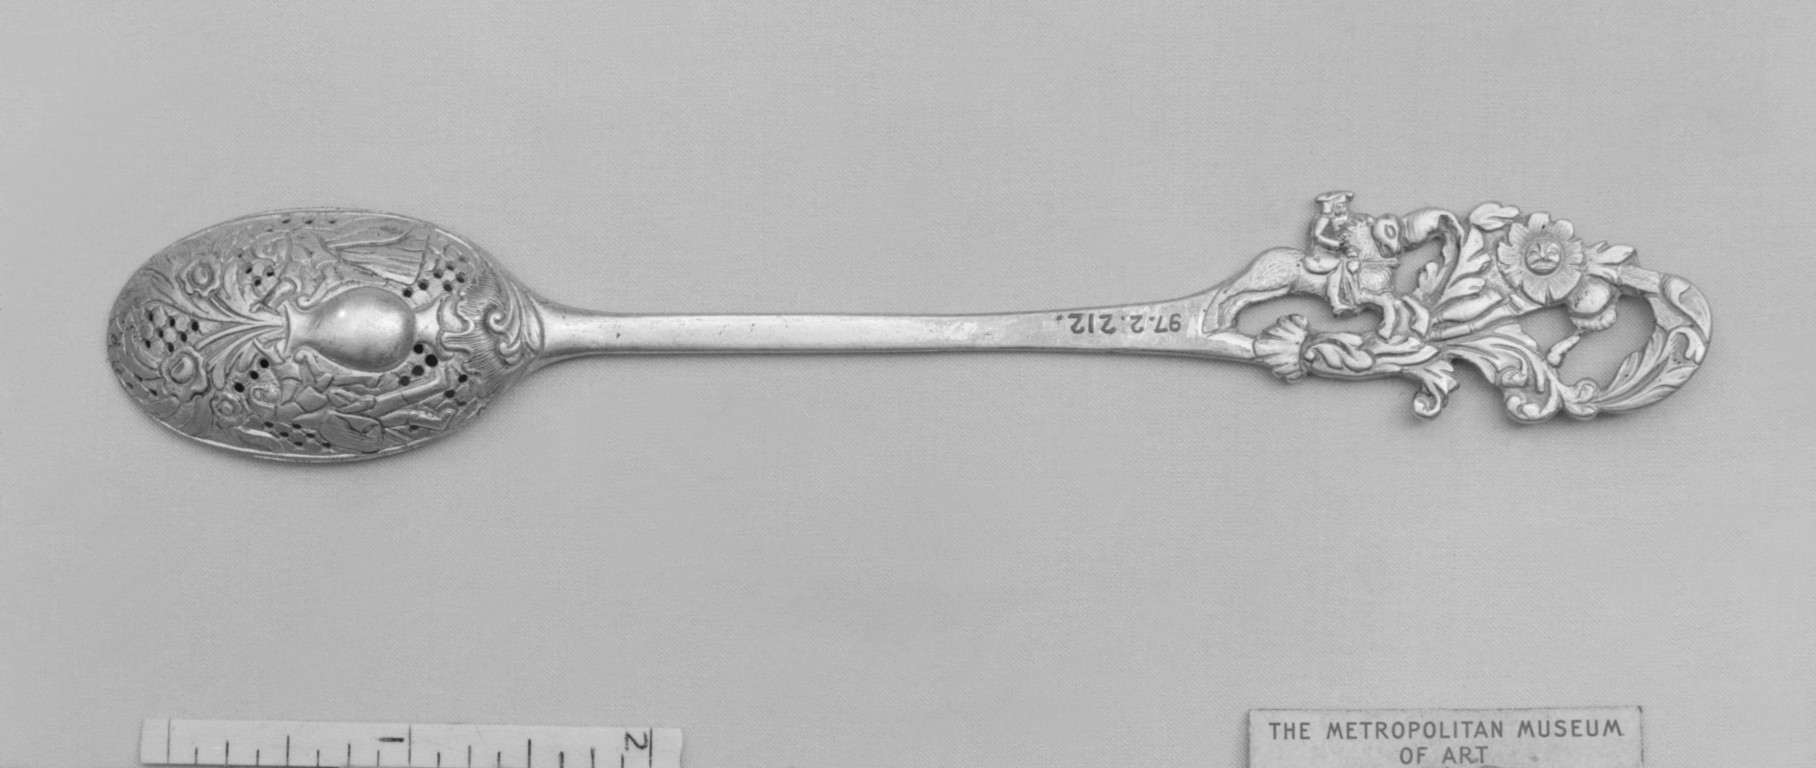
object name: strainer spoon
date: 1701-1800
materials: gilt, silver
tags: animals,men,flowers